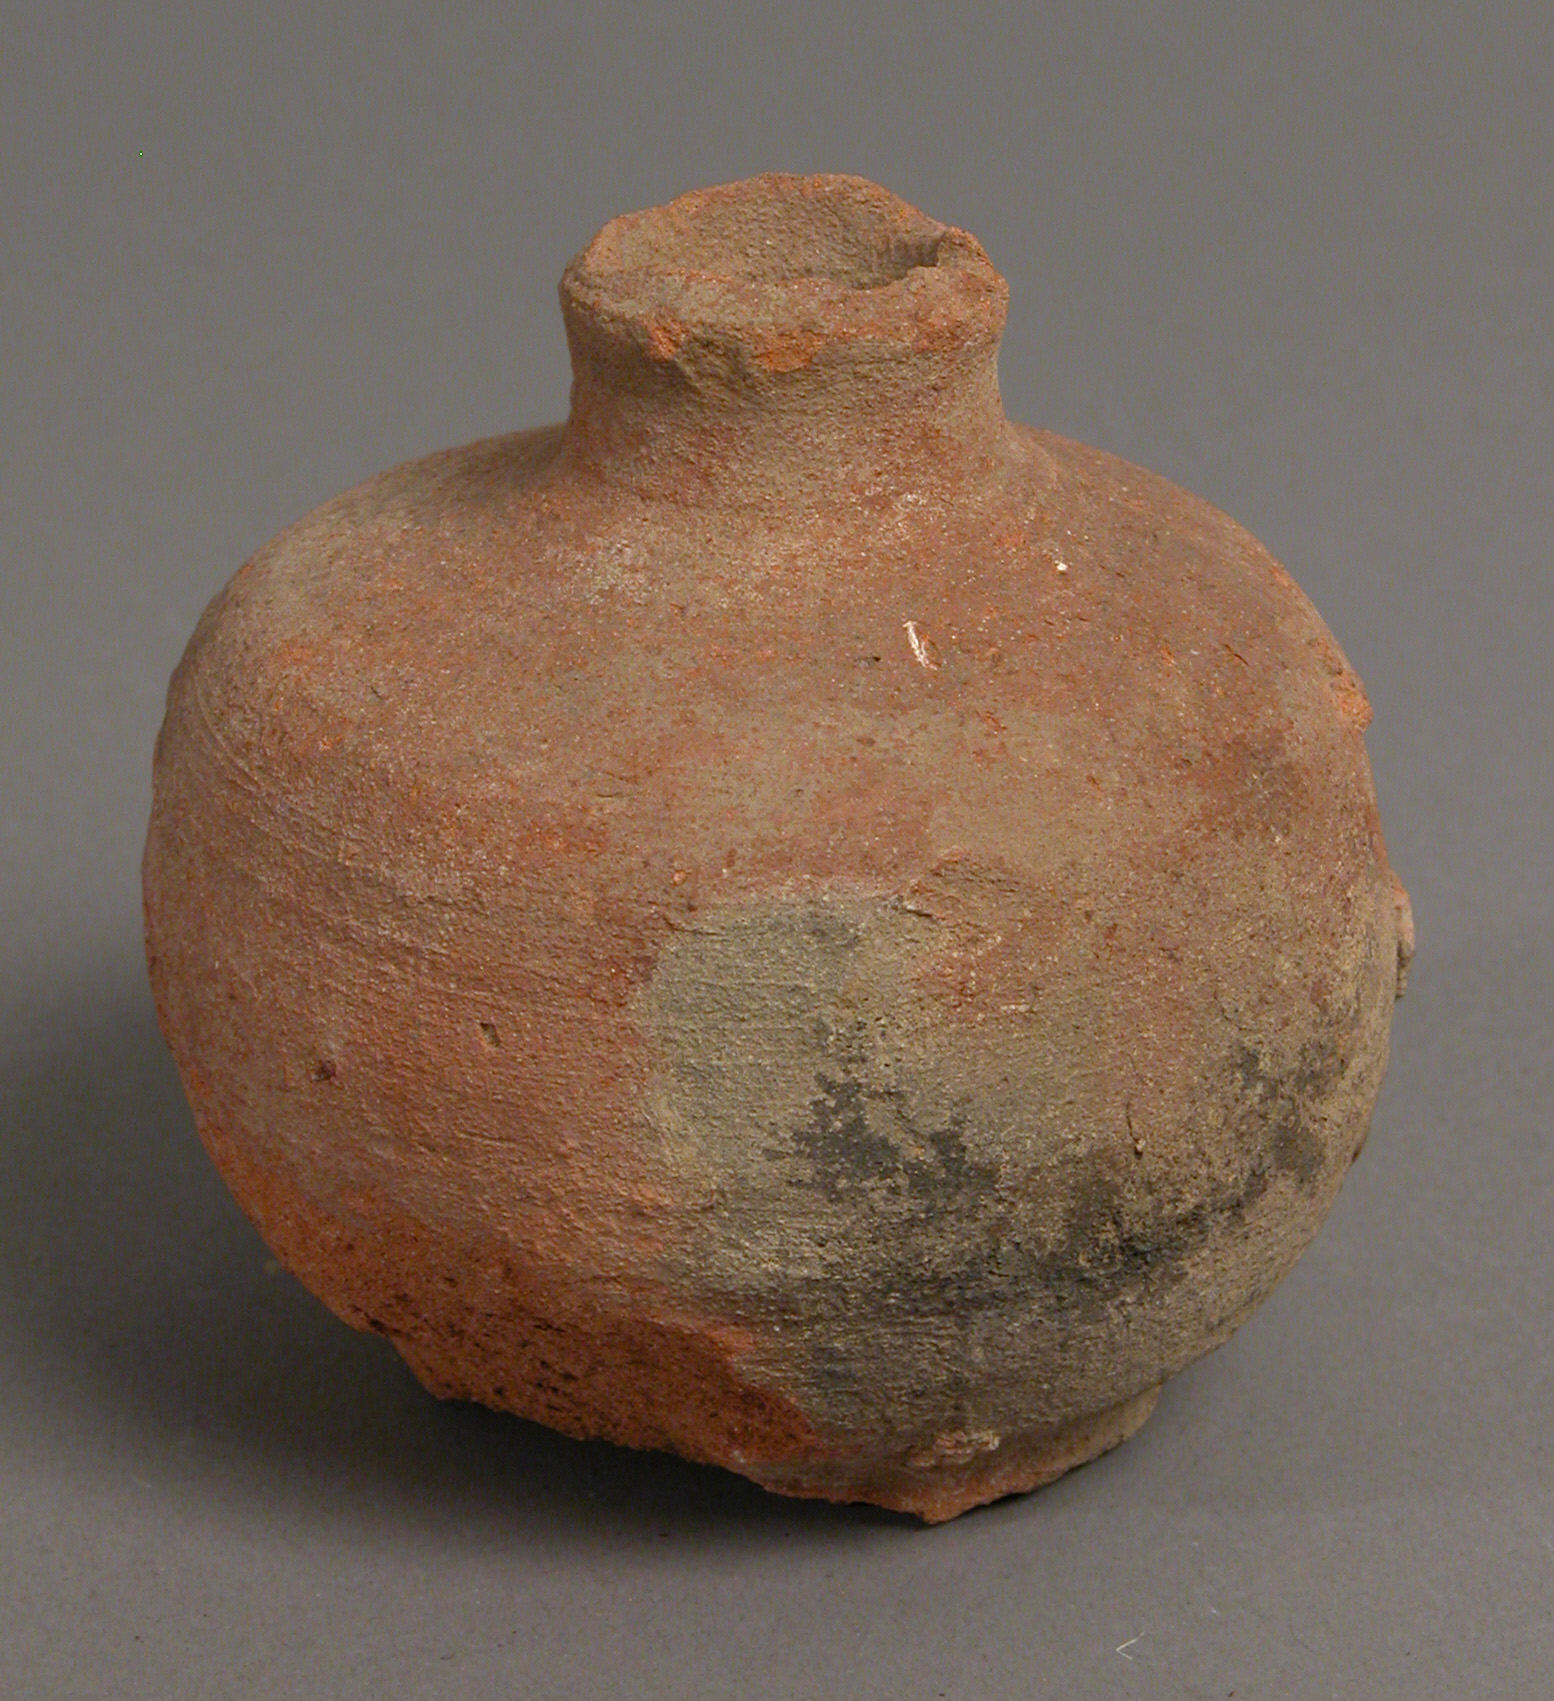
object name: pot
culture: coptic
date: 301-700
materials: earthenware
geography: egypt